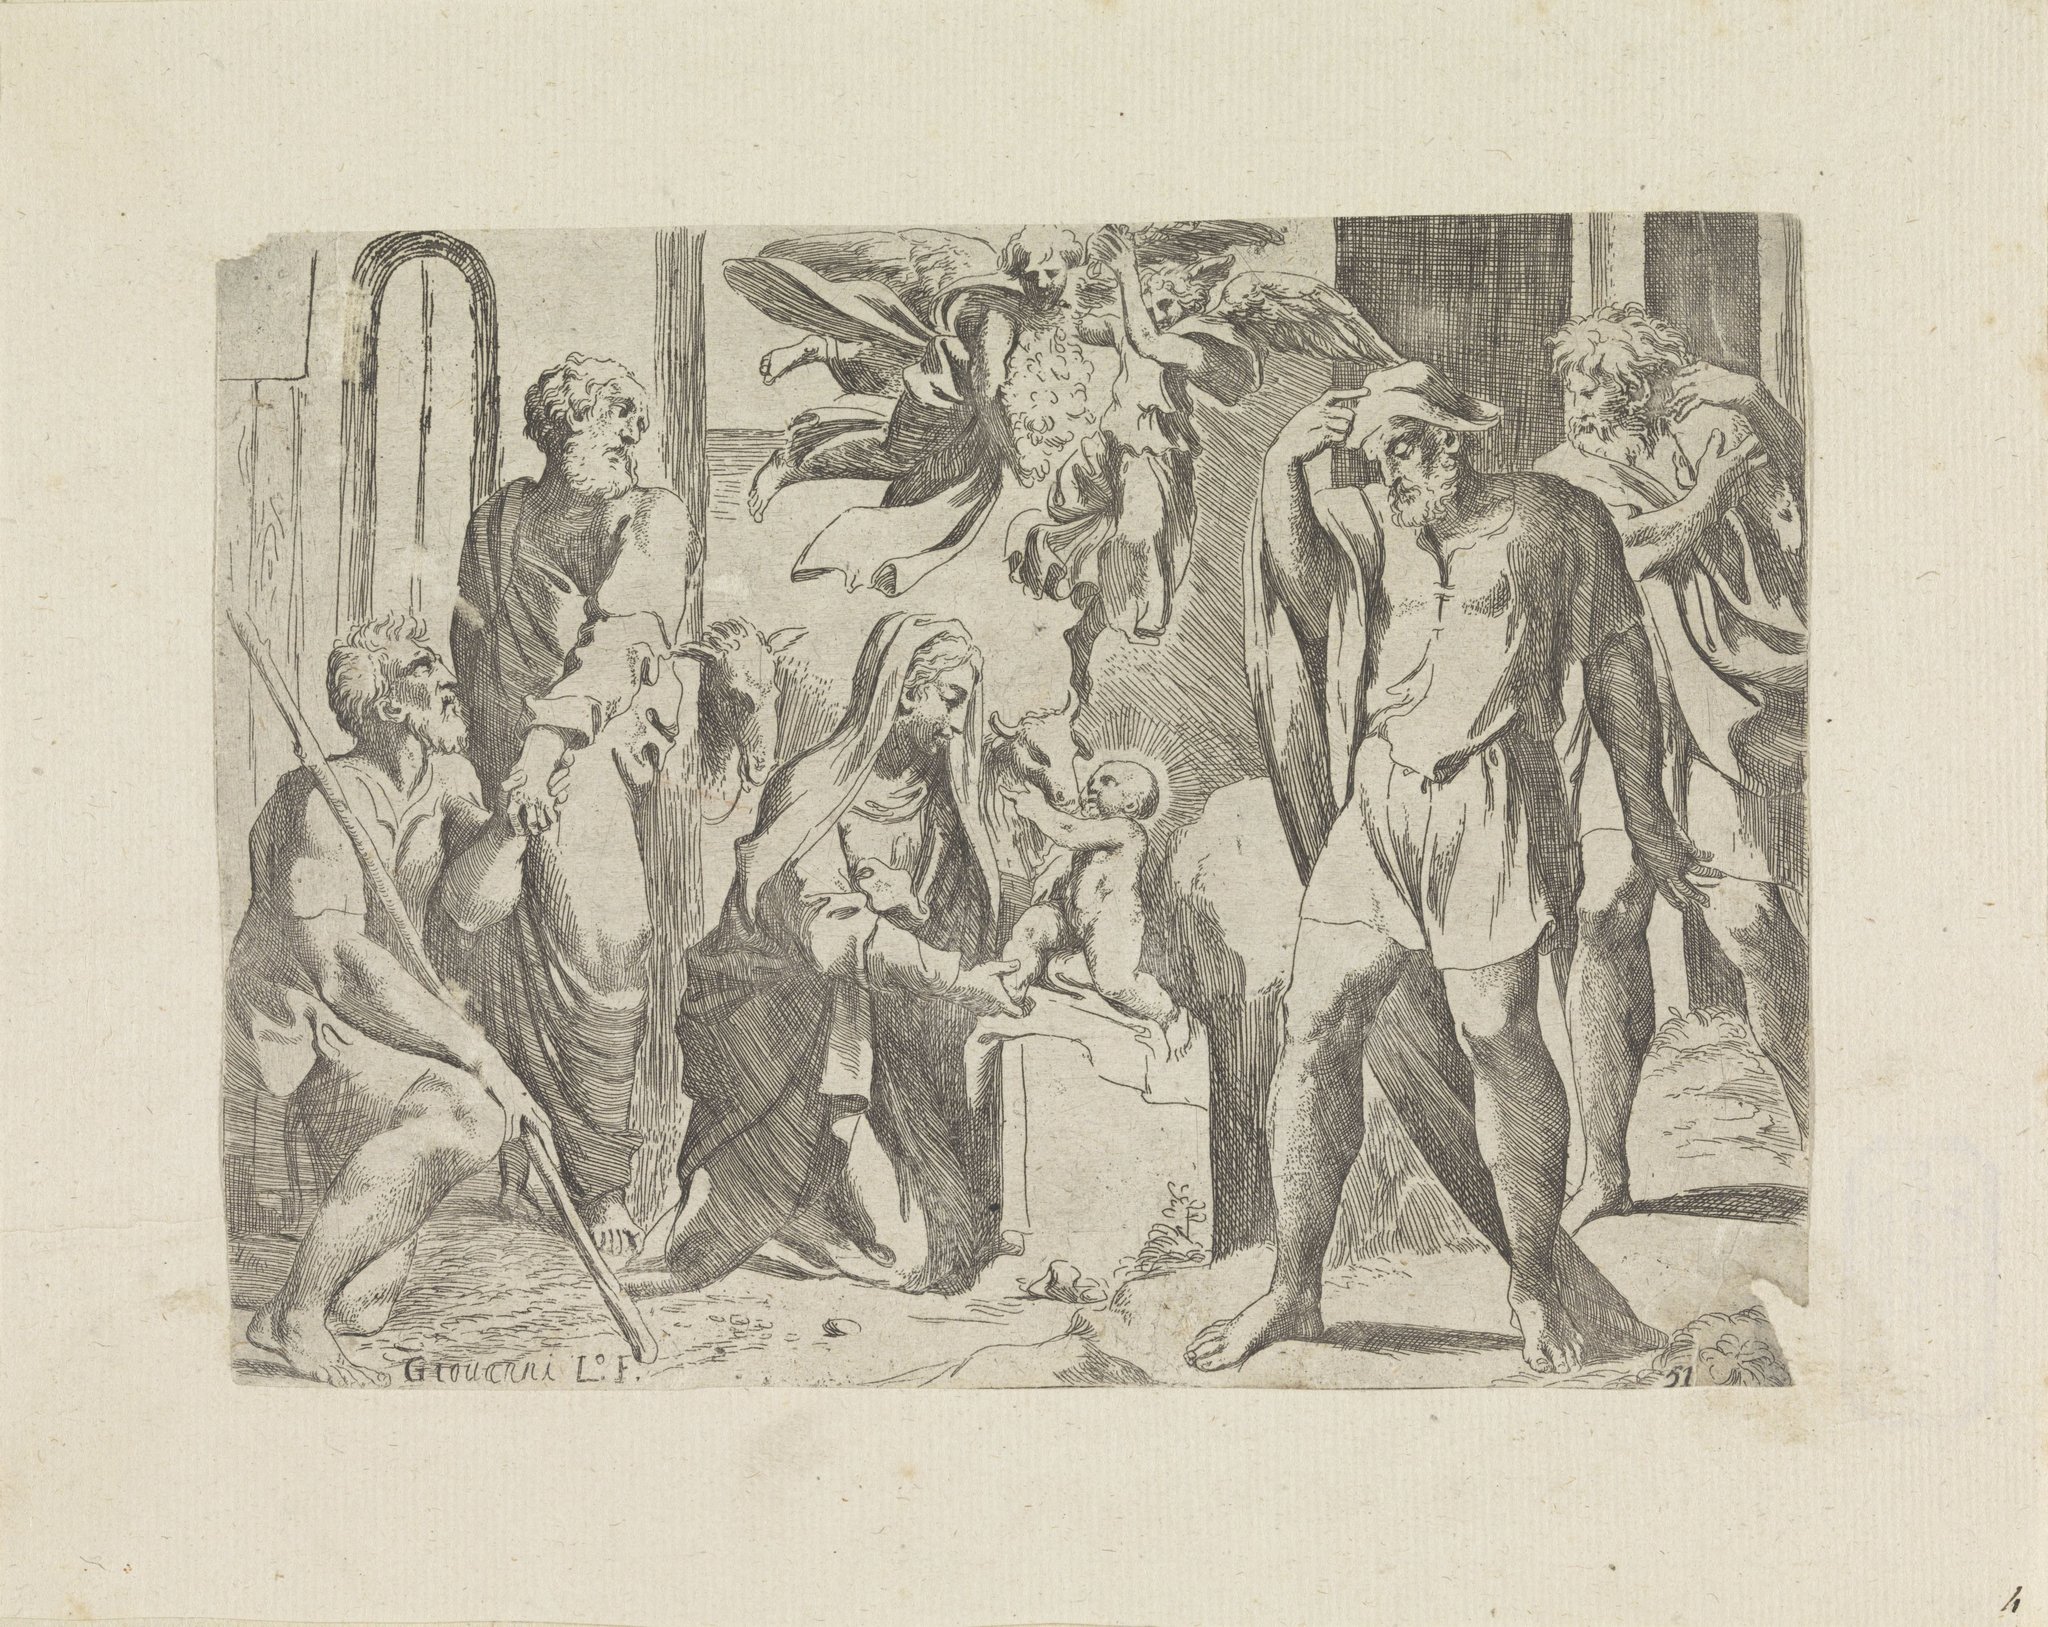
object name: print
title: Historia del Testamento Vecchio / Dipinta in Roma nel Vaticano da Raffaelle di Urbin (...)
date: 1607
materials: paper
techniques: etching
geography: rome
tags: adoration of the christ-child by the shepherds; mary and joseph present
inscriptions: collector's mark: Lugt 11, collector's mark: ‘Hinloopen’, number: ‘4’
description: Op een blad geplakt met rechtsboven handgeschreven in pen in bruin: 124. Prent uit een reeks van 54 genummerde prenten naar schilderingen in de Loggia van Rafael in het Vaticaan.